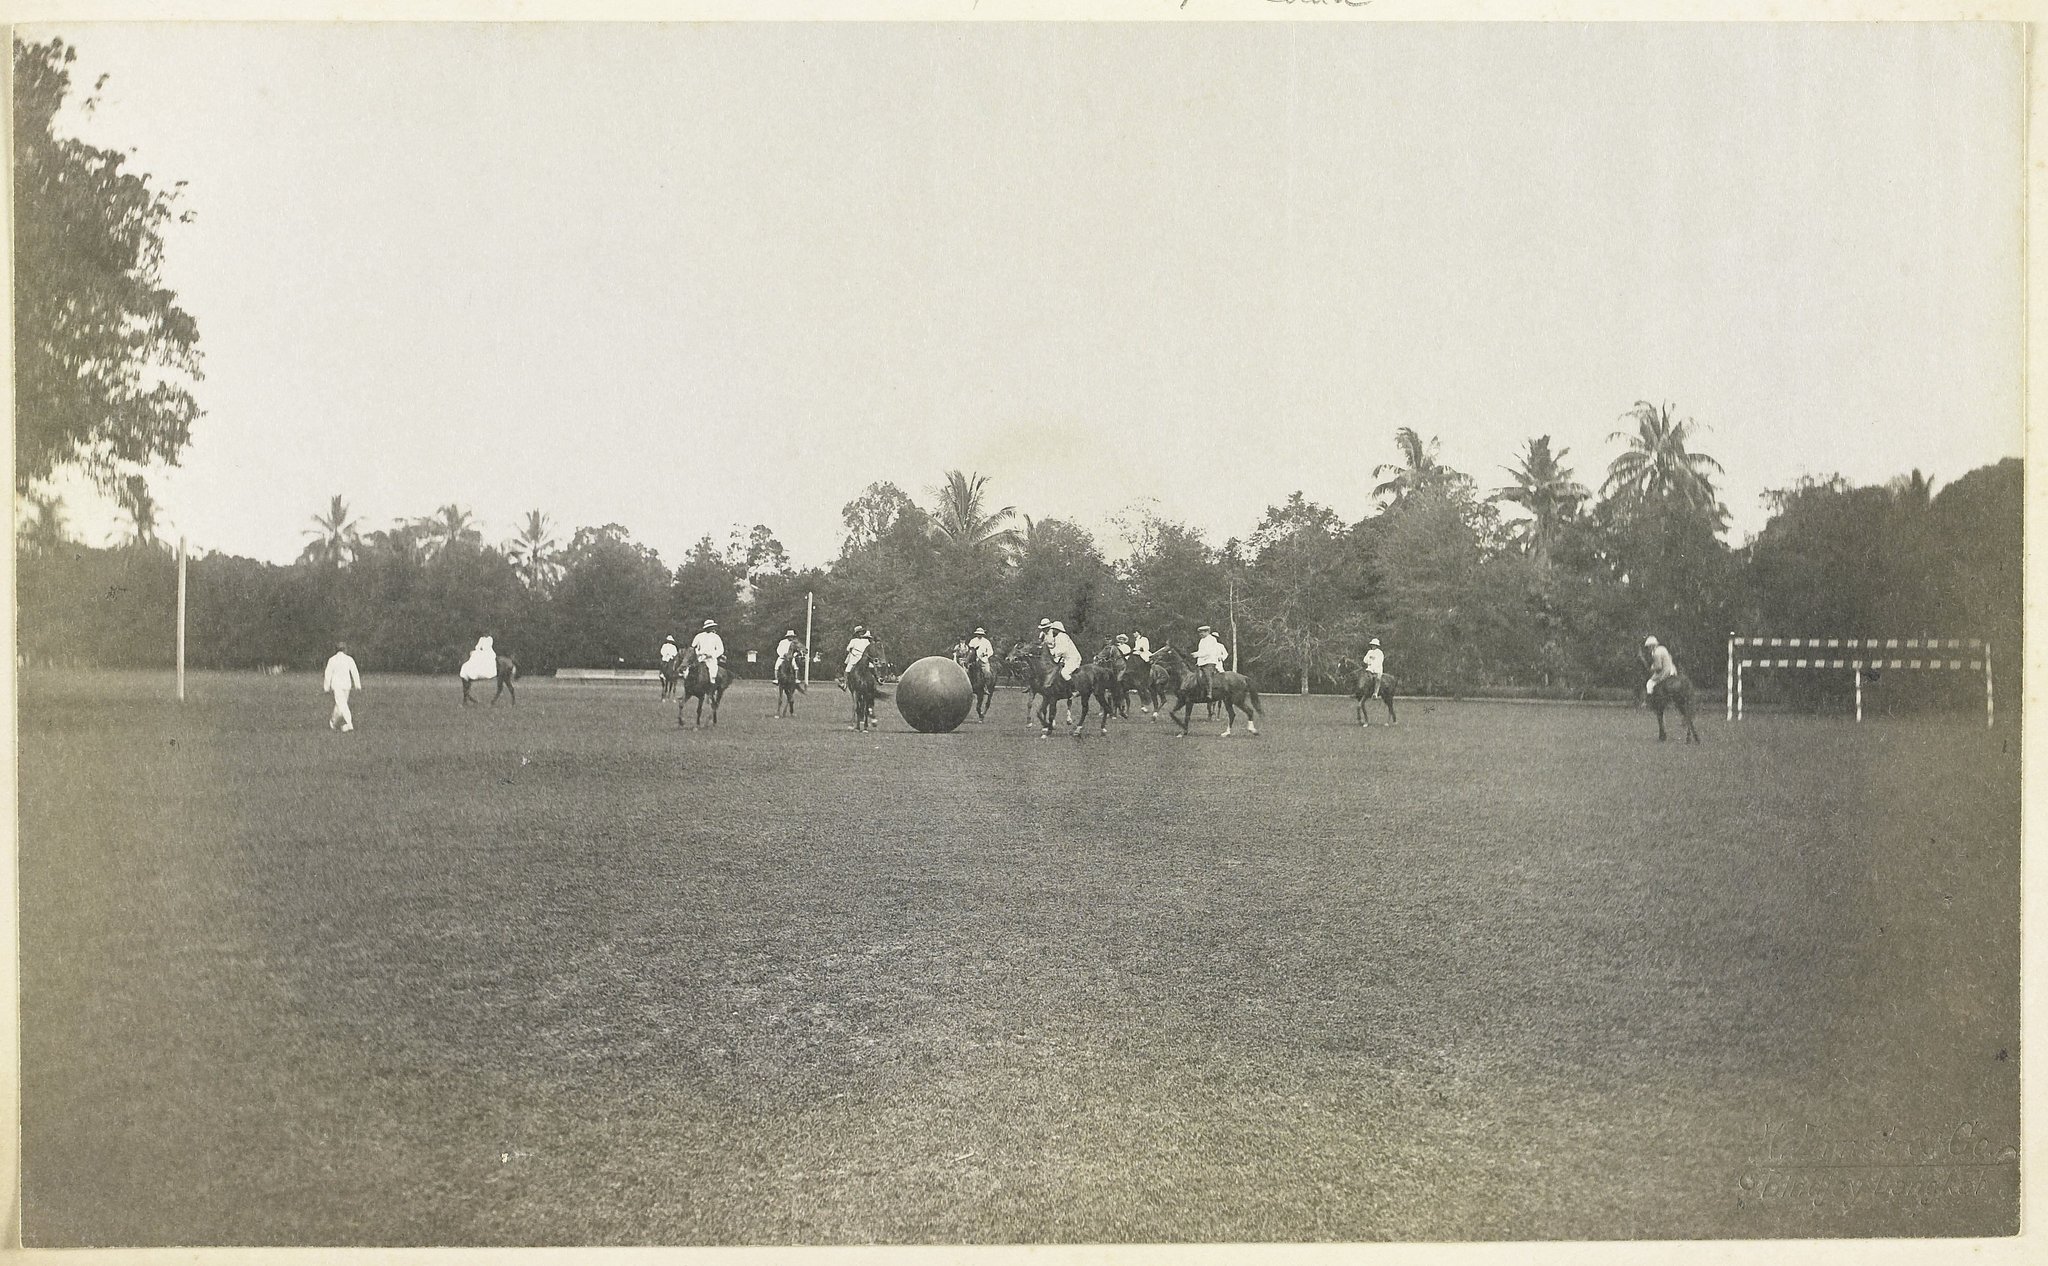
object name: photograph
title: Ruiterspel met grote bal, Medan Sumatra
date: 1900-1905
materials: cardboard, paper, photographic support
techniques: platinum process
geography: bindjai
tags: sumatra